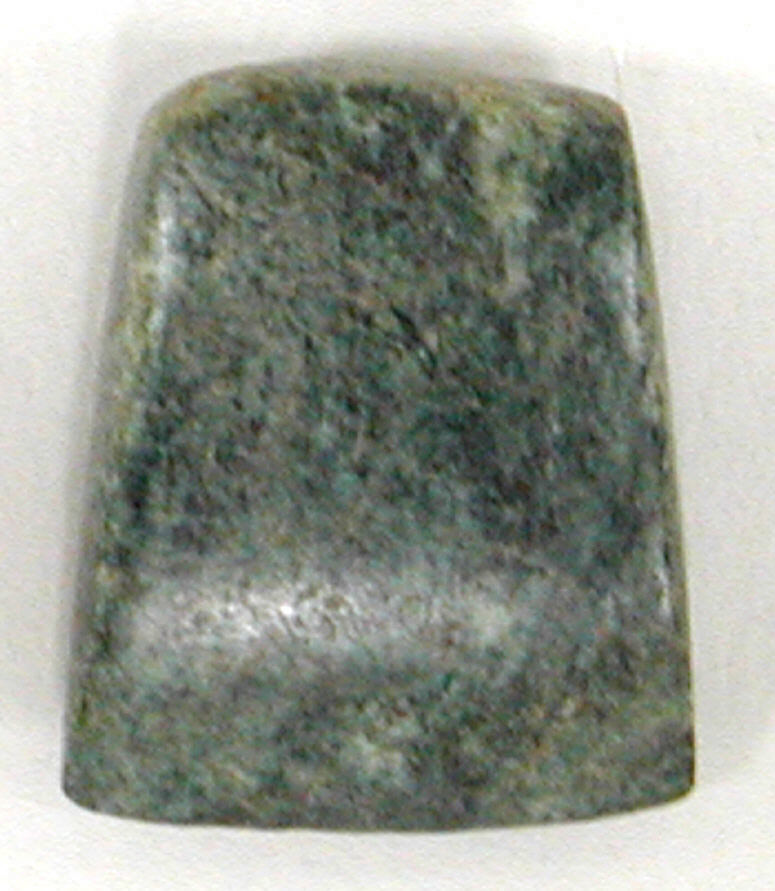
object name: chisel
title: Stone Chisel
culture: mexican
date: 1501-1600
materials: stone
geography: mexico